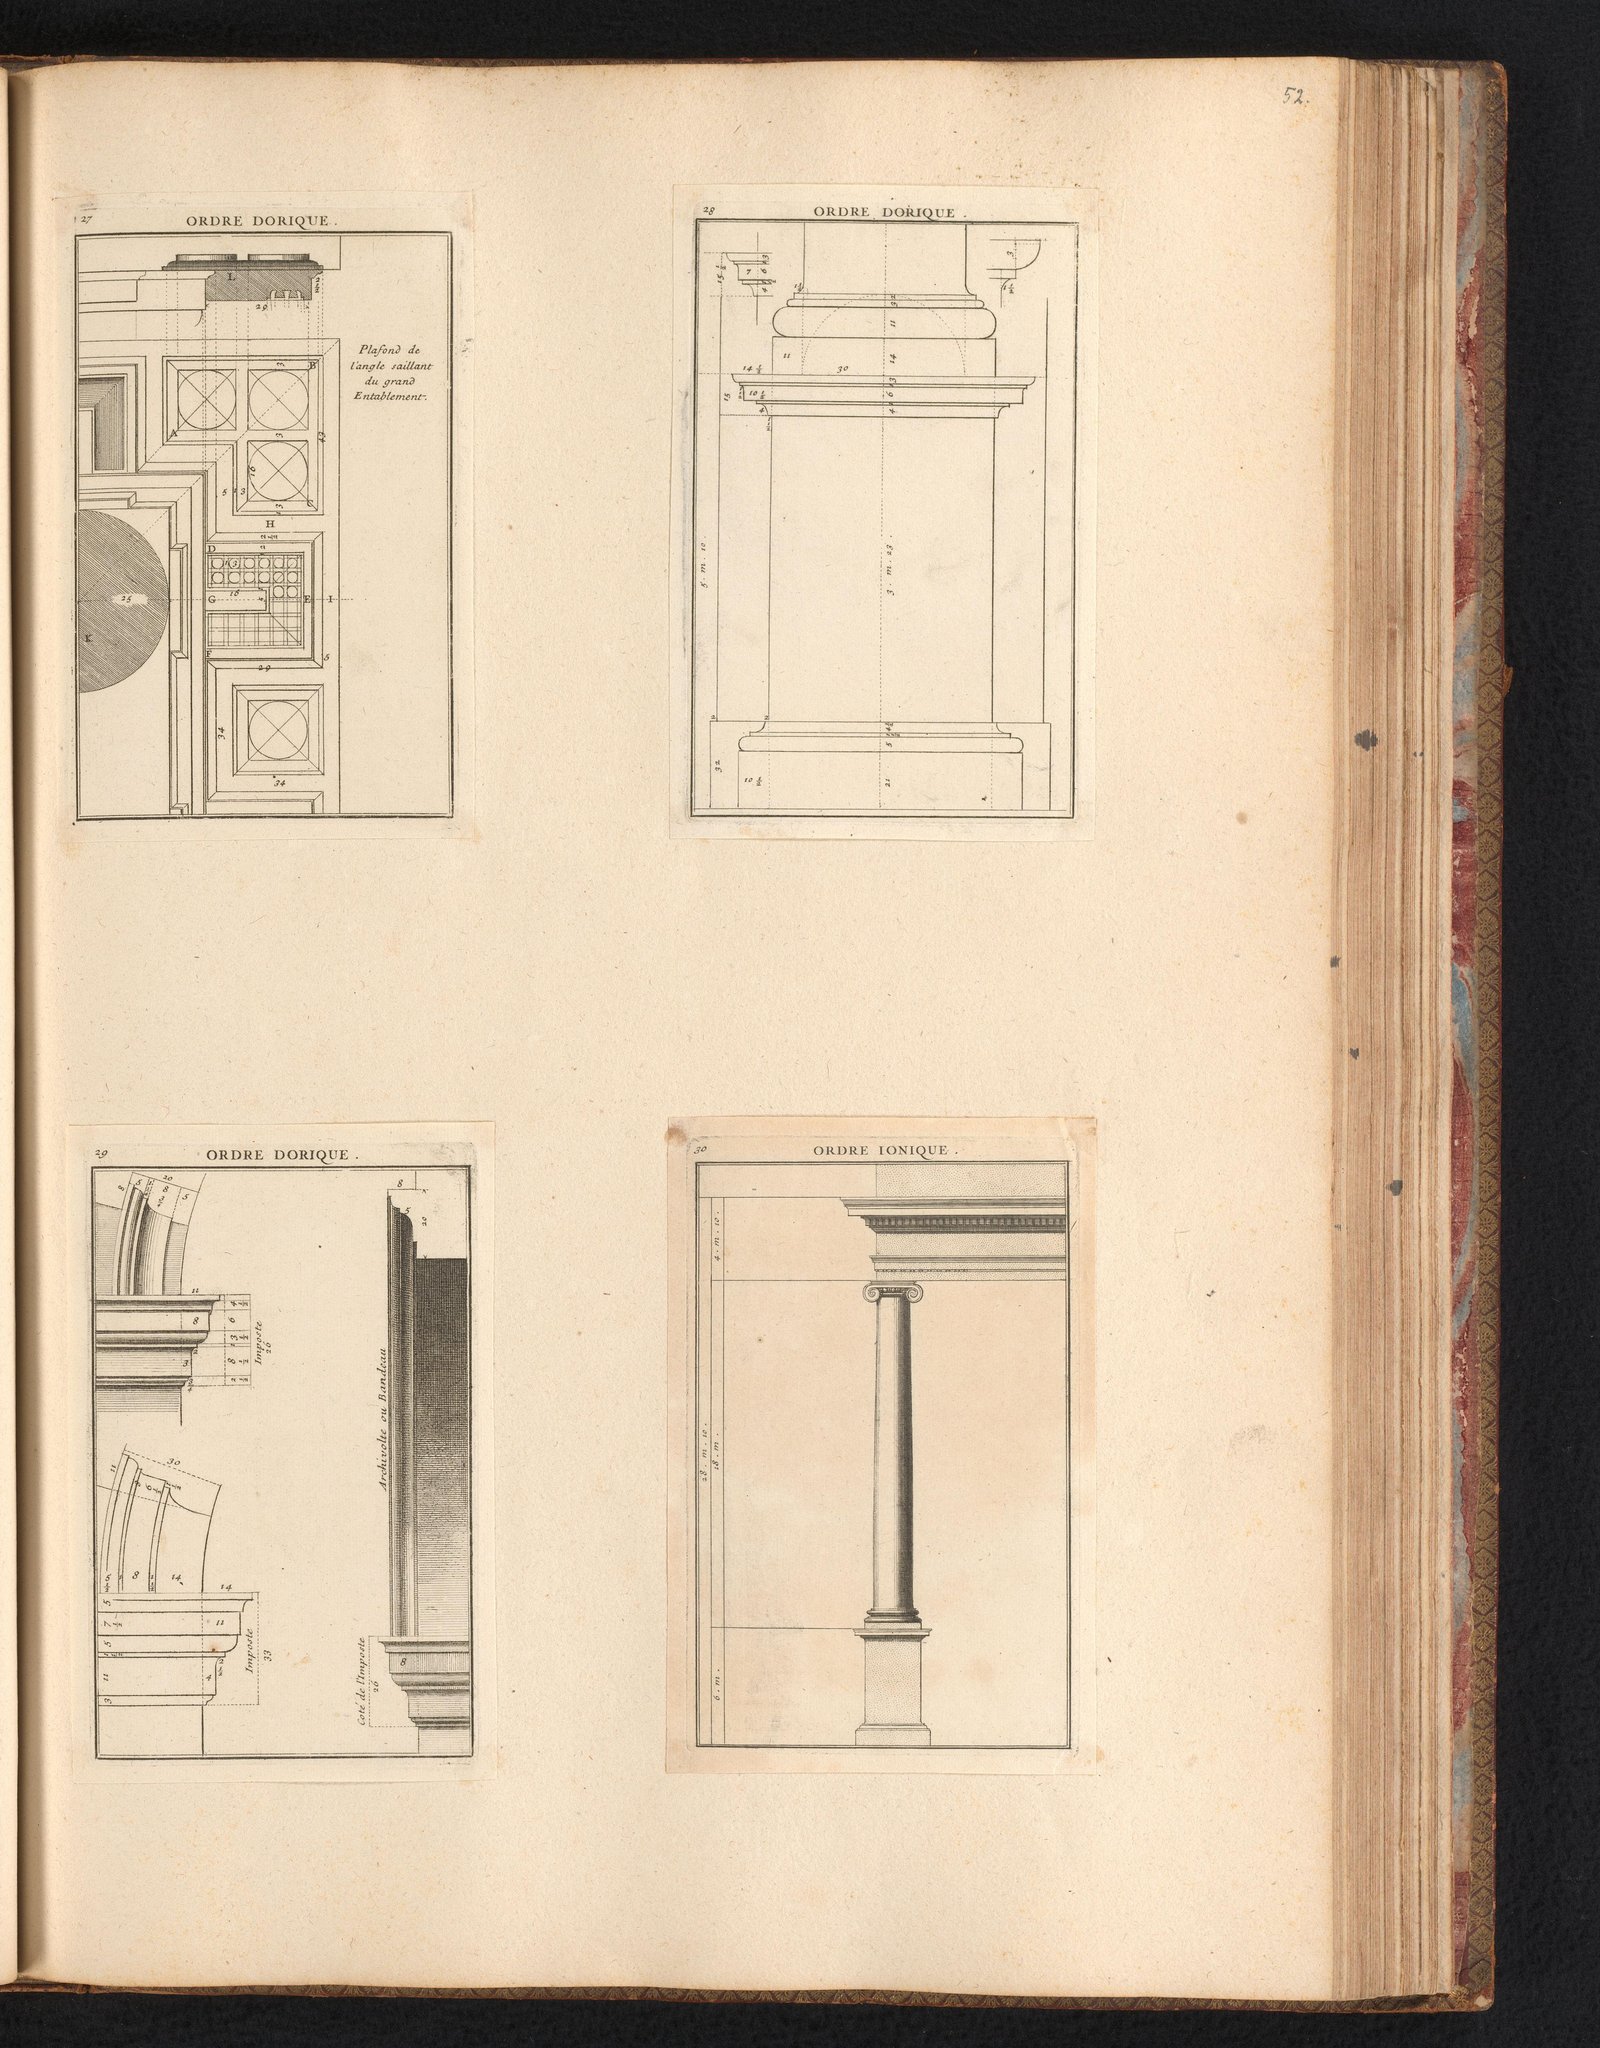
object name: album leaf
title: Ordre Dorique/ Ordre Ionique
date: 1714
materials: paper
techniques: etching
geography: paris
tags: doric order ~ architecture, ionic order ~ architecture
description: Prenten uit: Leclerc, Sébastien (I). Traité d'architecture. Parijs: Pierre François Giffart, 1714.